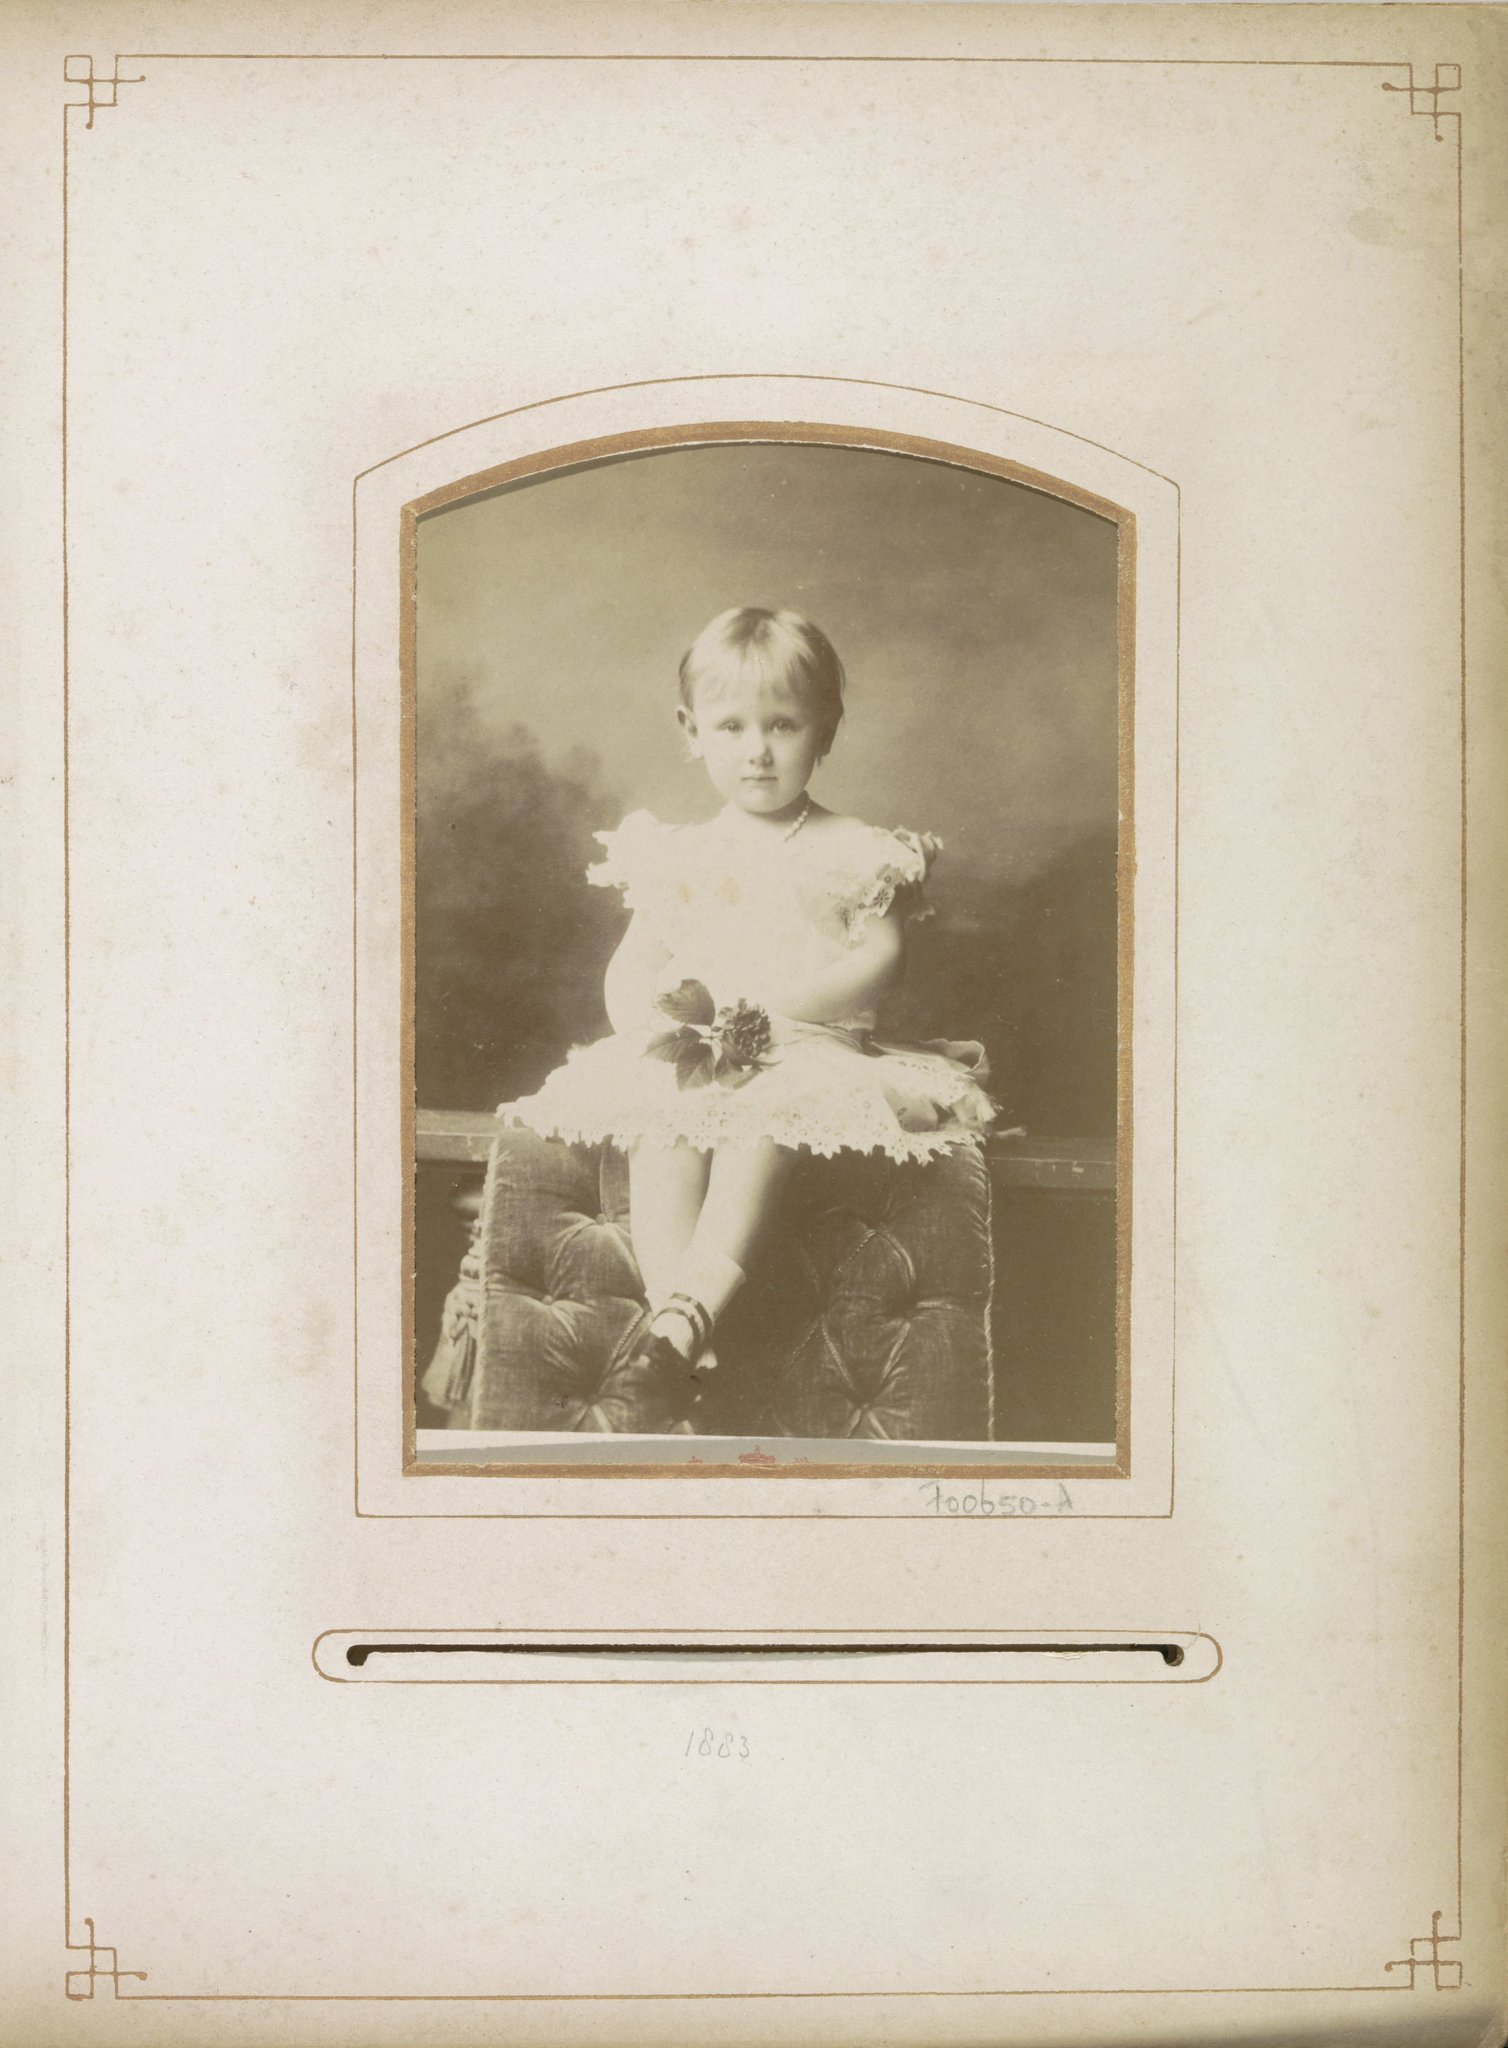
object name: cabinet photograph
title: Portret van prinses Wilhelmina als kleuter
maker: kameke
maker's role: painter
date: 1883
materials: cardboard, paper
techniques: albumen print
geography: the hague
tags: the hague, wilhelmina of the netherlands, historical persons - bb - woman, toddler (female)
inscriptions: inscription: ‘'s Gravenhage/ Kameke./ Arnhem/ Gedeponeerd.’